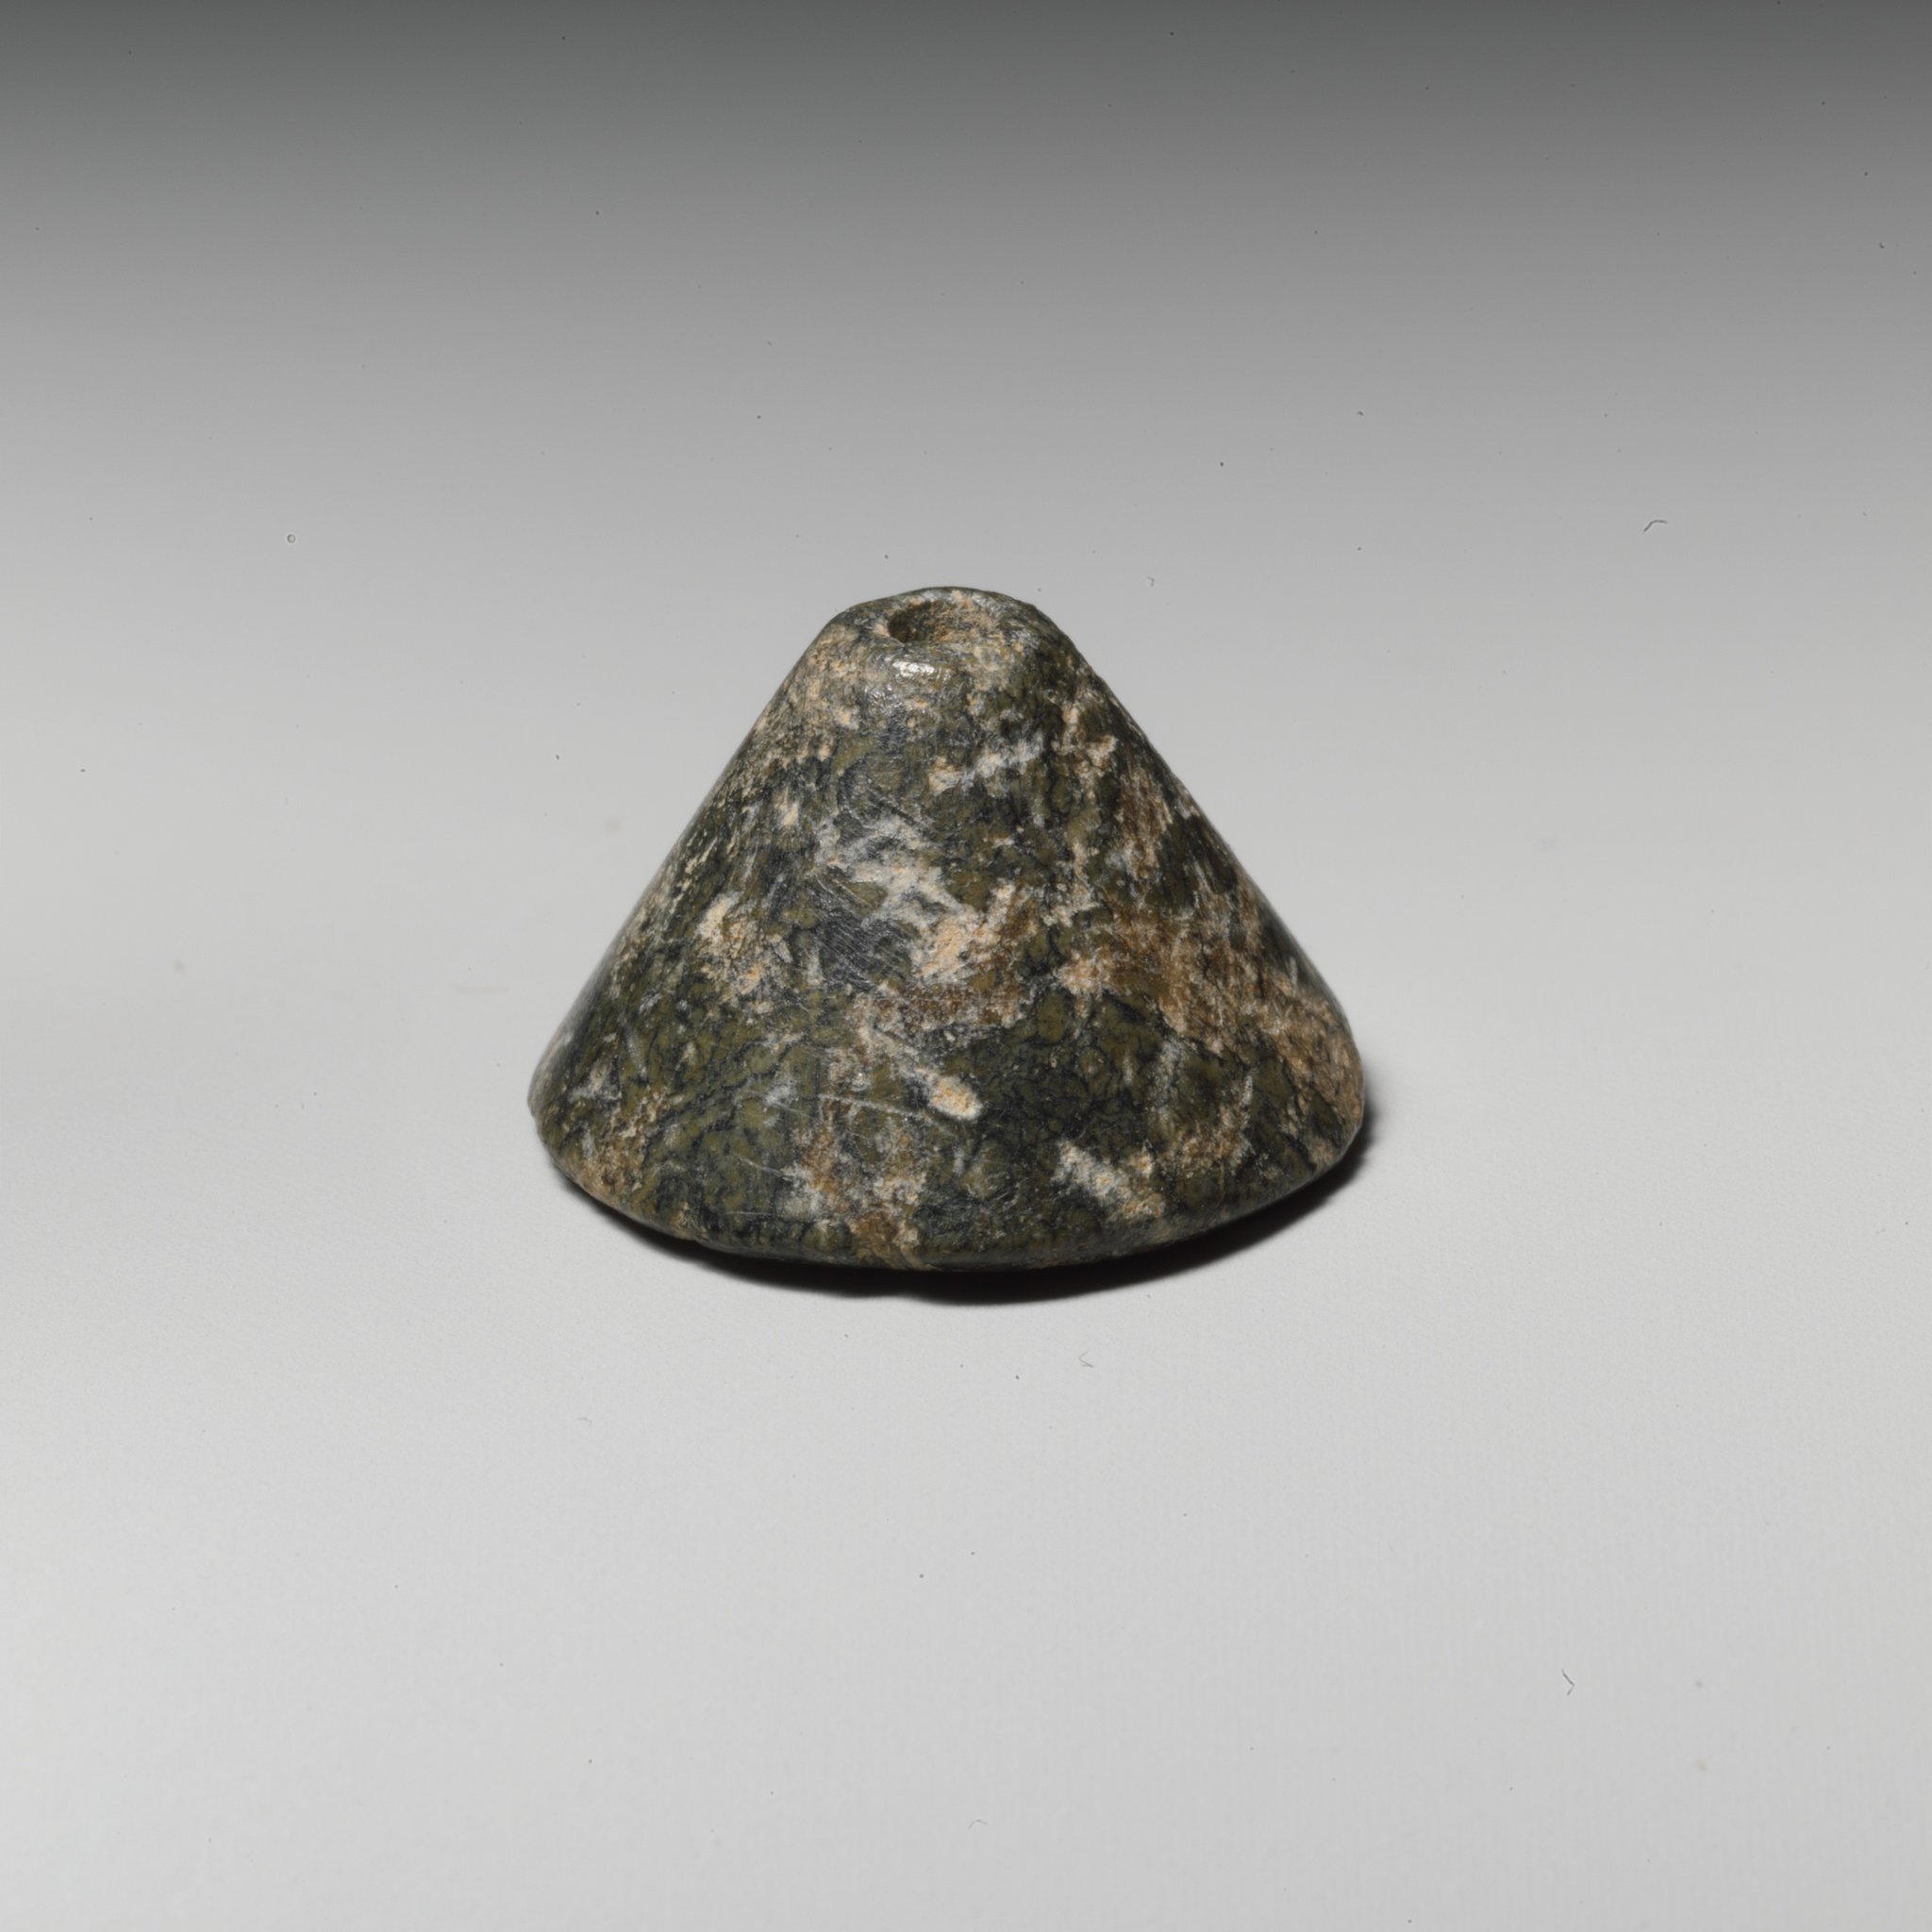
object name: spindle whorl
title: Stone spindle whorl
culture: minoan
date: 2400-1900 BCE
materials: stone